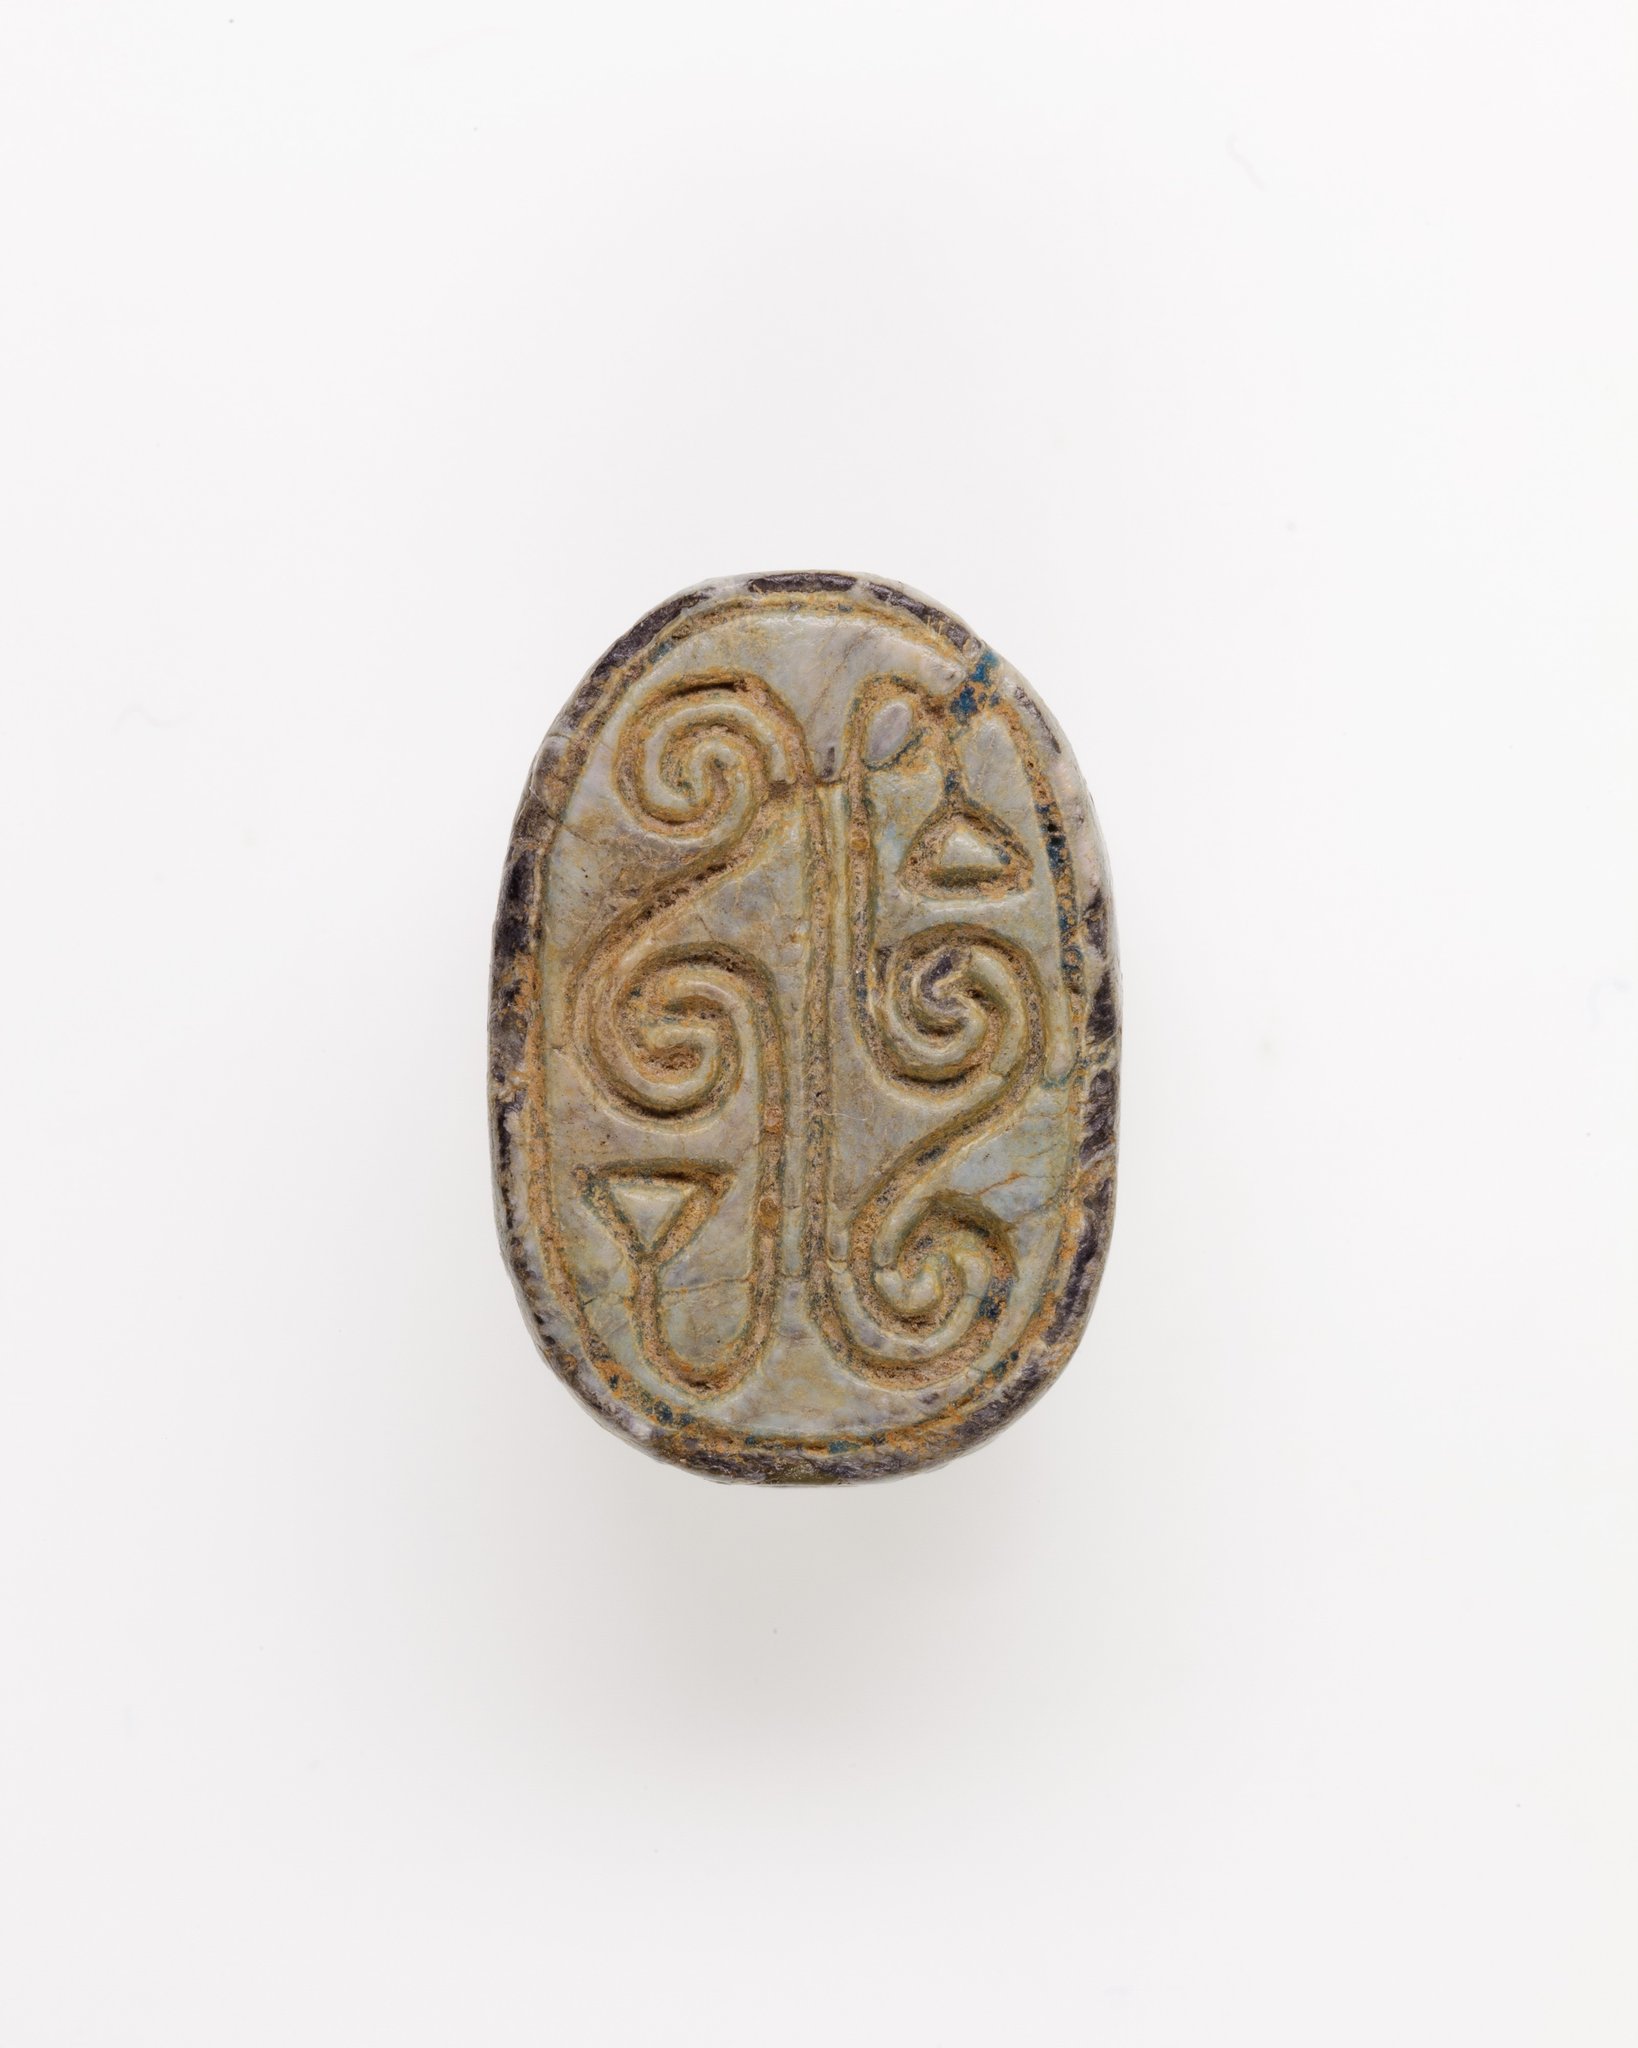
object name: scarab, papyrus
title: Scarab Decorated with Scrolls and Papyrus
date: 1740-1640 BCE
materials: stone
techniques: glazing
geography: egypt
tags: scarabs